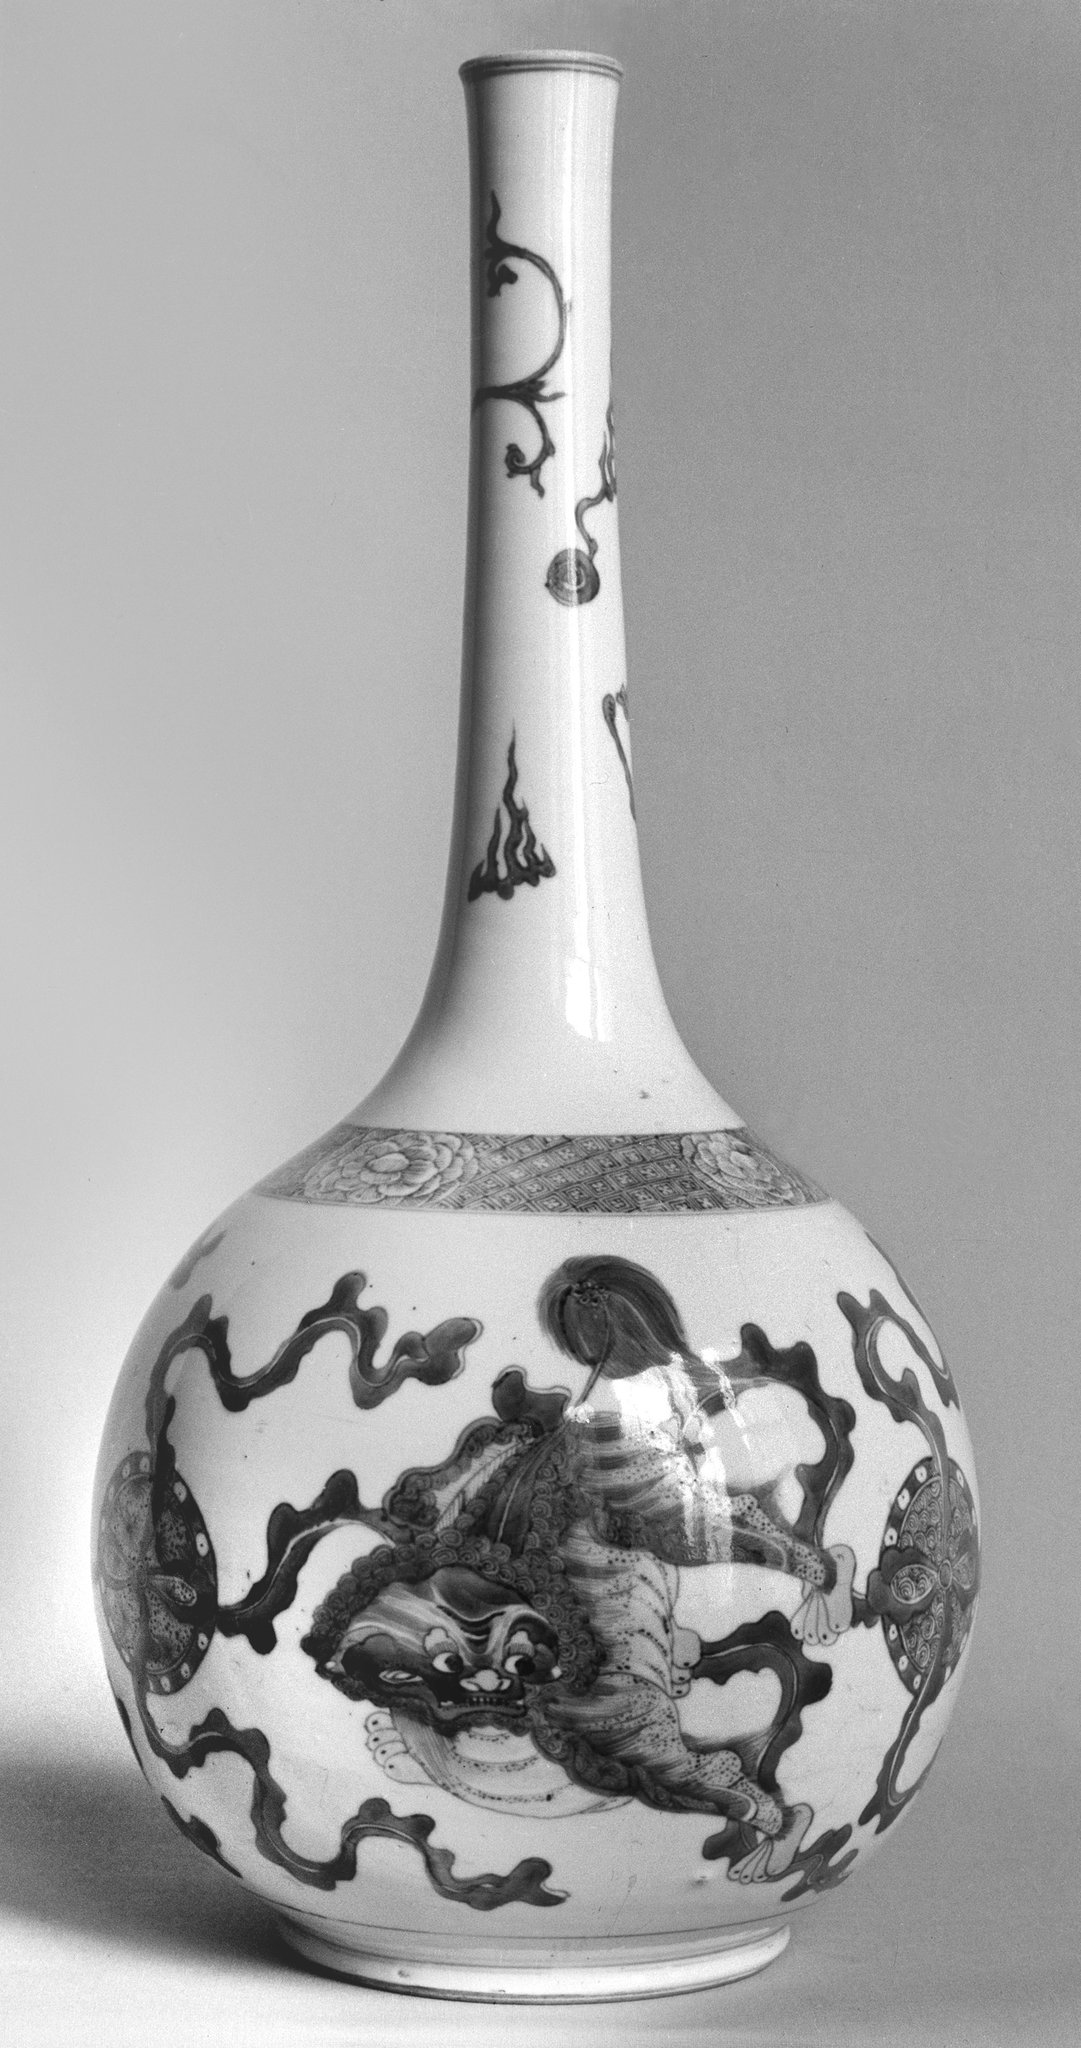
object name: bottle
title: Long neck bottle with lions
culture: chinese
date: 1701-1733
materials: cobalt, porcelain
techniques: painting, underglaze